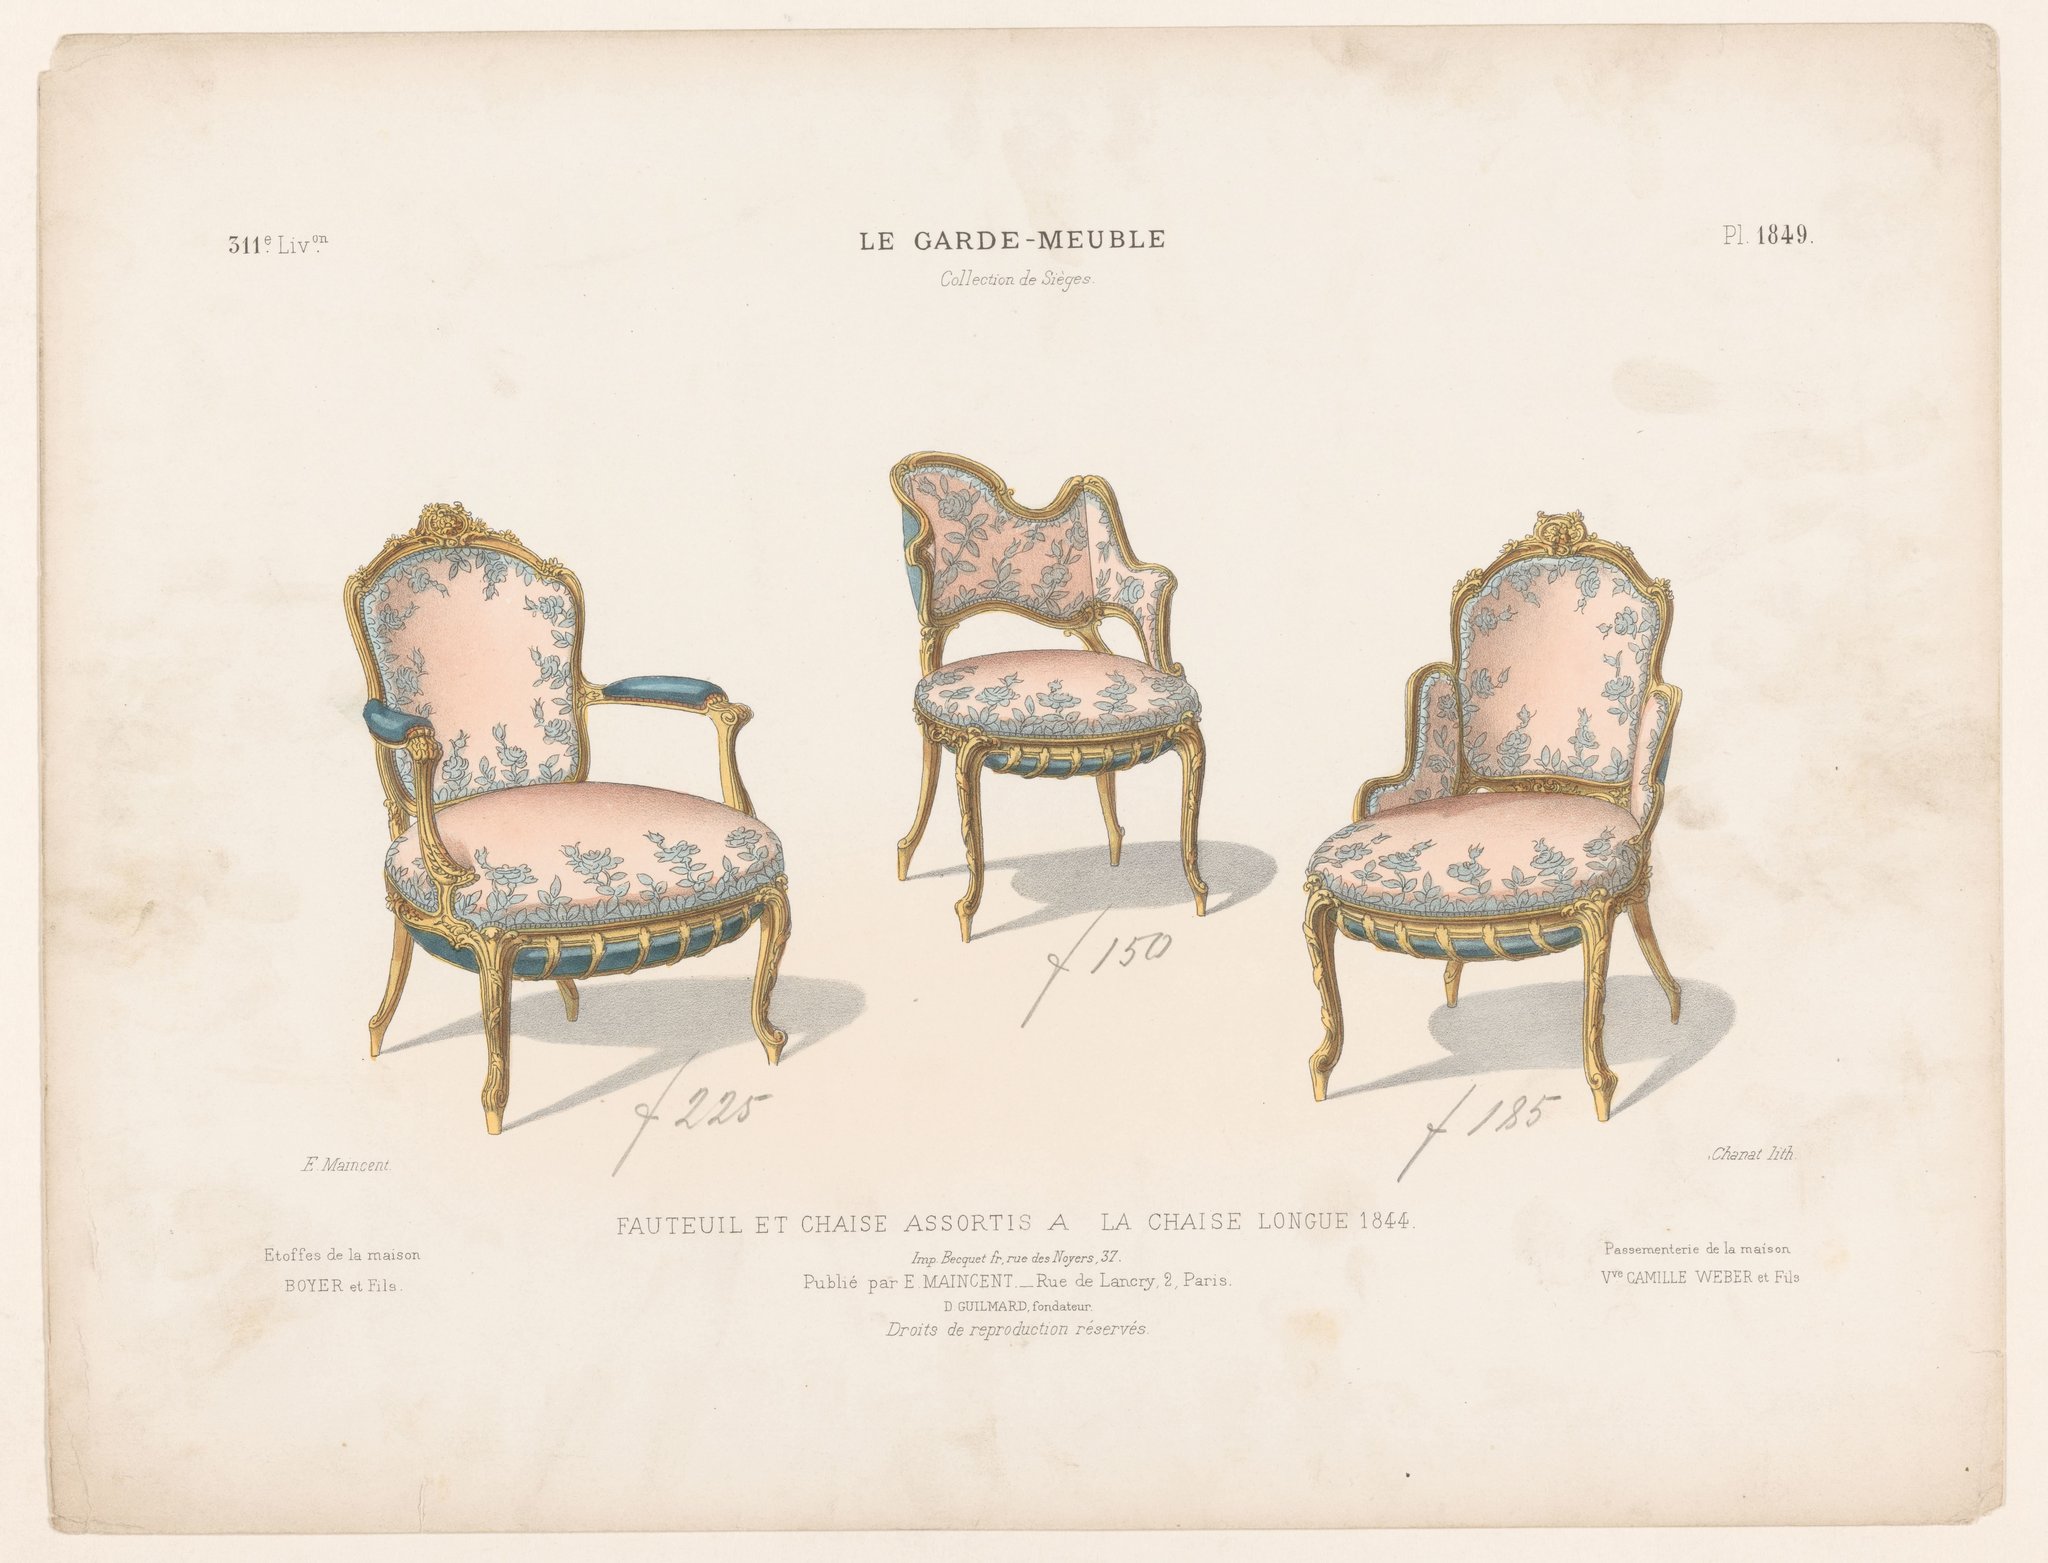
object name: print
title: Le garde-meuble / Collection de Sièges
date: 1885-1895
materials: paper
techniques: hand coloring, lithograph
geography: paris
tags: seating furniture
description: Ieder Livraison in de serie Le Garde-Meuble bevat negen platen: drie 'sièges' (zitmeubels), drie 'meubles' (diverse meubels zoals tafels en kasten) en drie 'tentures' (gordijnen en draperieën).